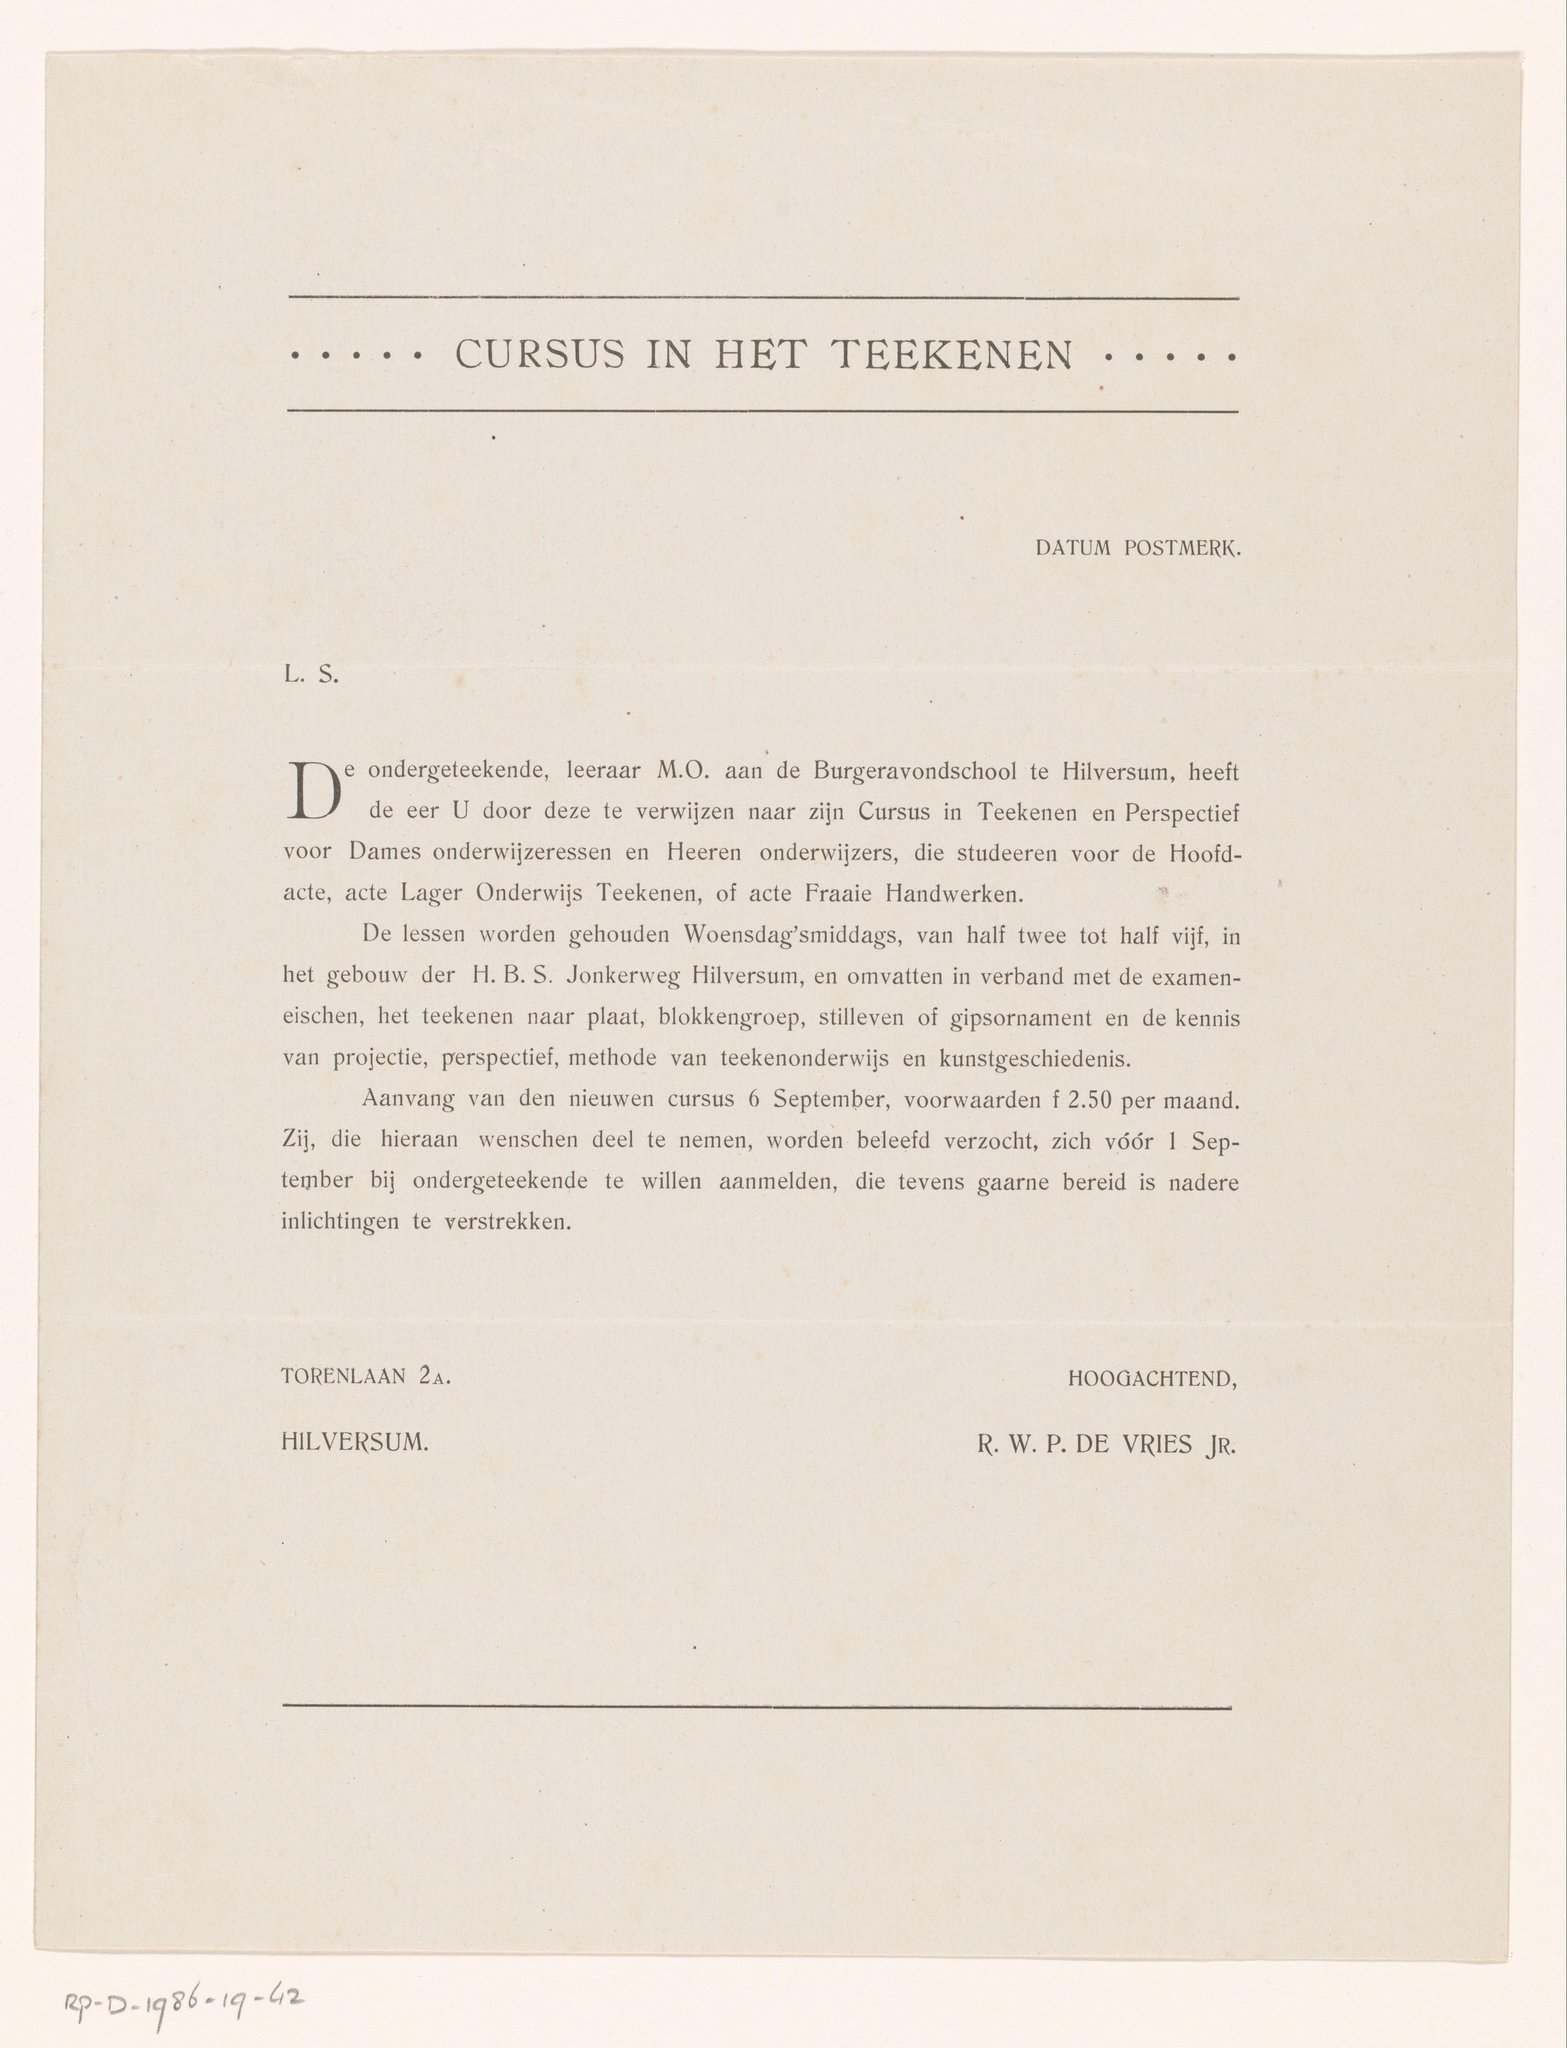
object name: letter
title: Brief aan anoniem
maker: reinier willem petrus de vries (1874-1953)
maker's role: draughtsman, print maker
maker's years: 1874-1953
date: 1884-1952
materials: paper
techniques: typewriting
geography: hilversum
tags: education, tuition of the artist (in general)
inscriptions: collector's mark: ‘R:MVS.’